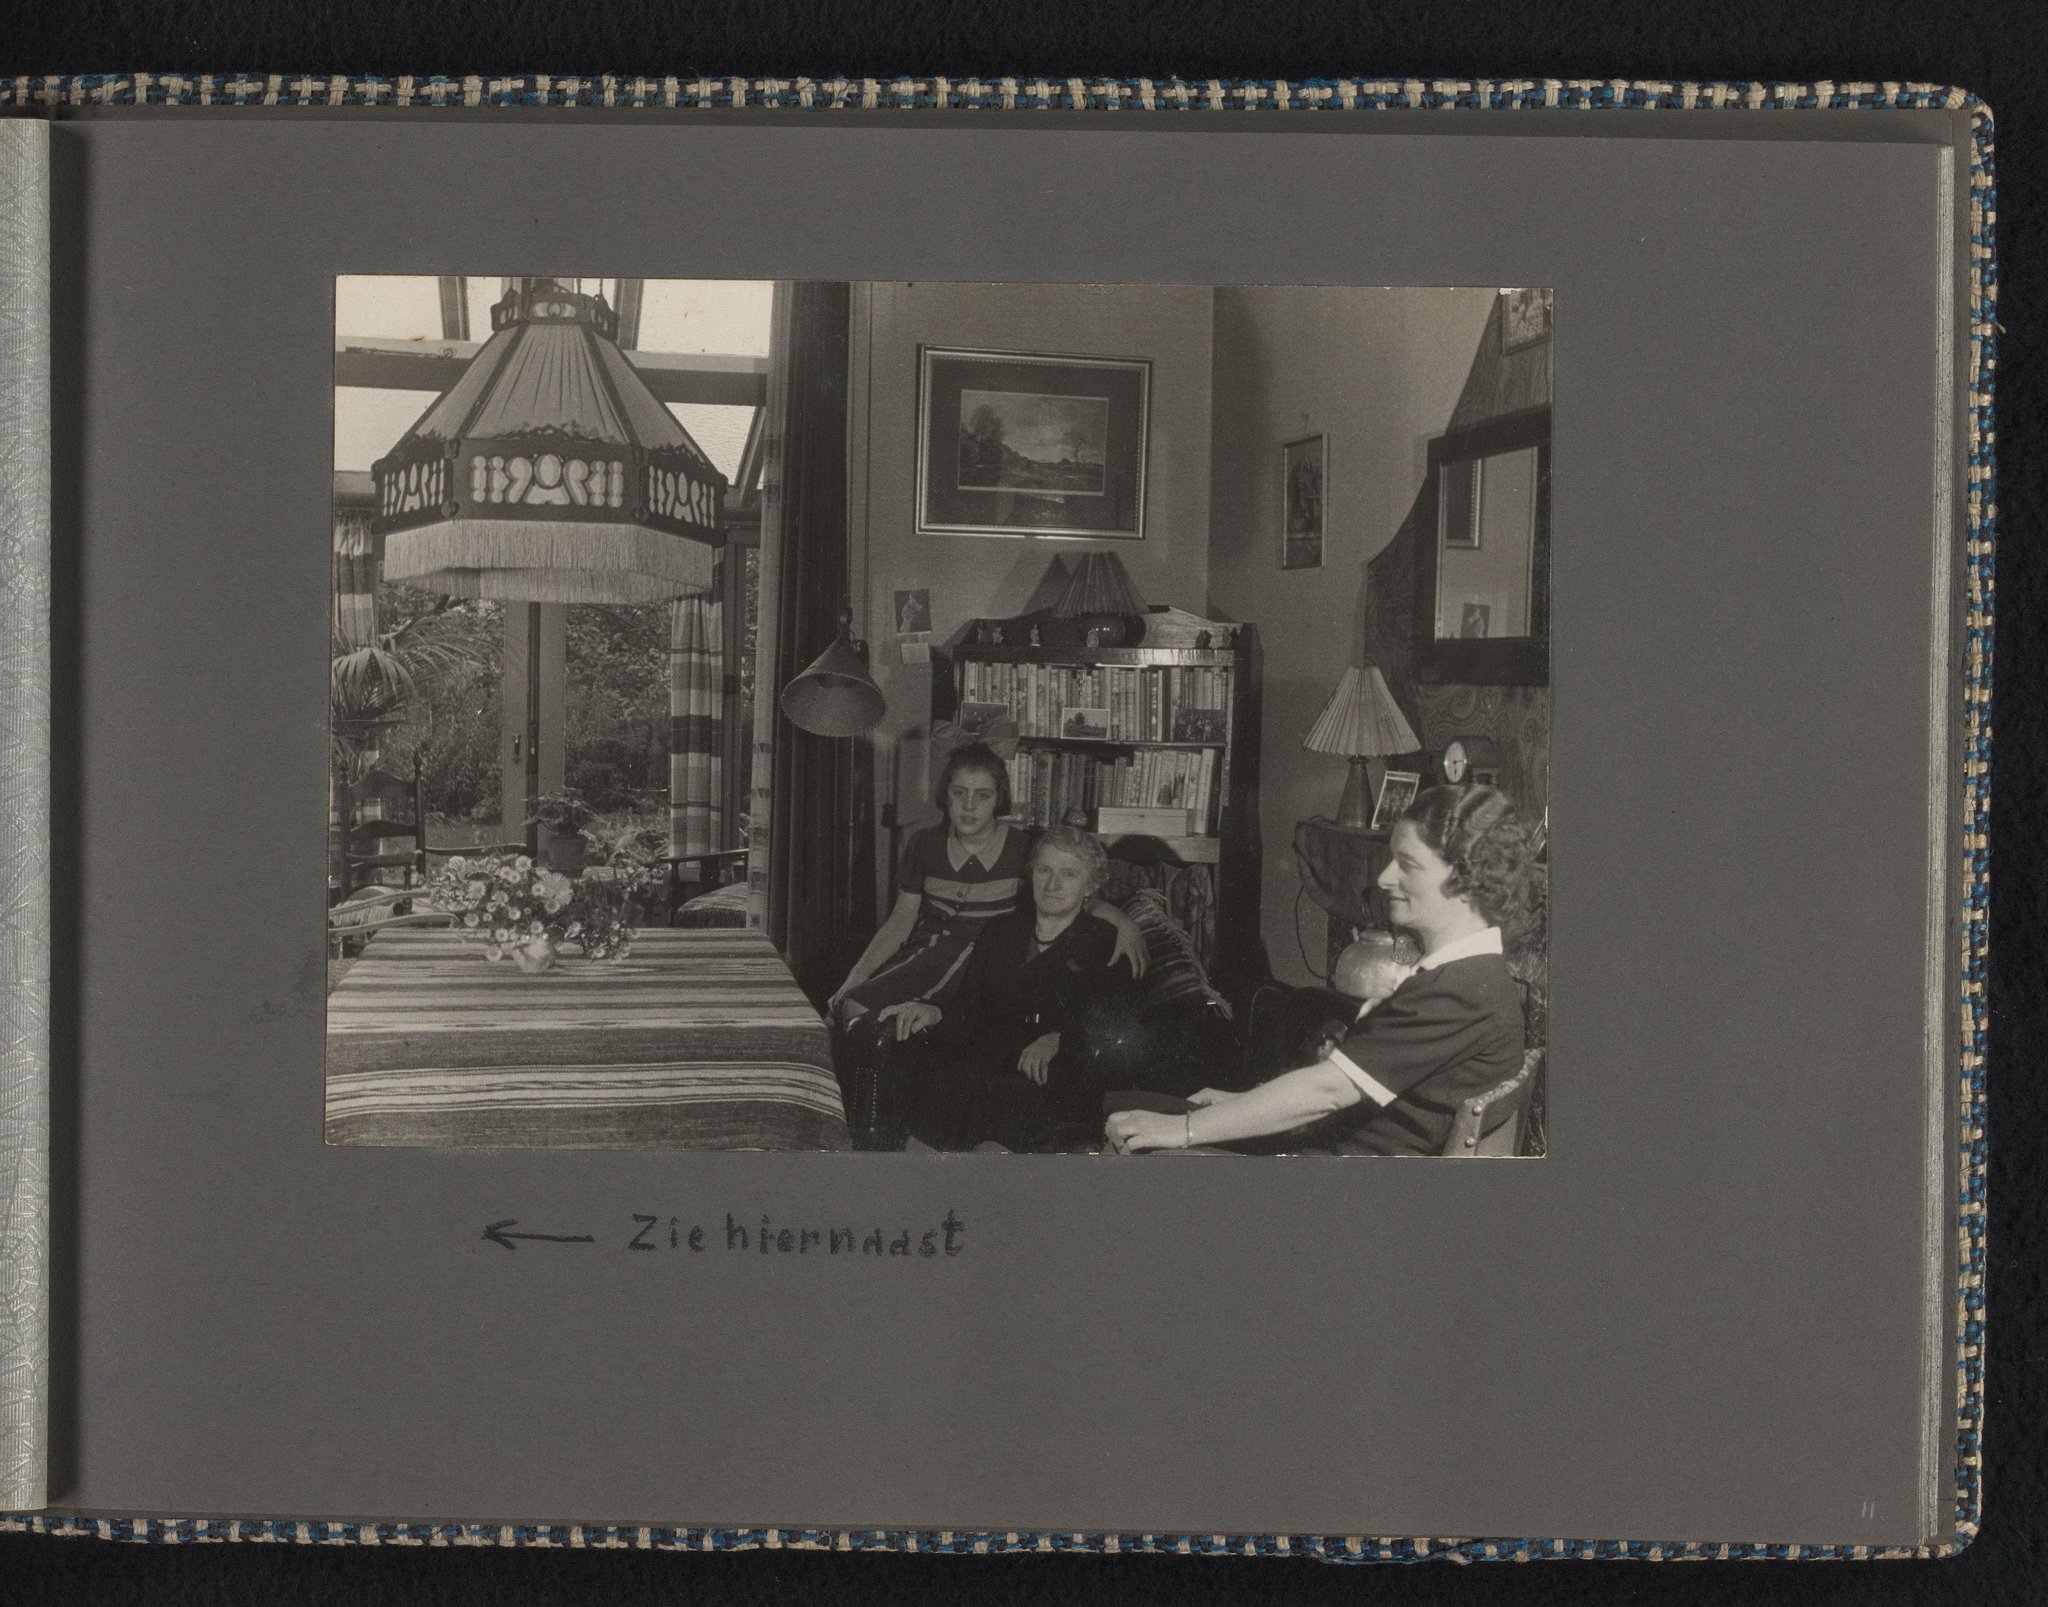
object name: photograph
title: Herfst 1943 in achterkamer Breelaan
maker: Anonymous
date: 1943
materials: paper, photographic support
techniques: gelatin silver print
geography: netherlands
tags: family life at home, mother and daughter(s) (family group), netherlands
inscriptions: inscription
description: Albumblad met een foto van de moeder met dochter en een oudere vrouw, in de achterkamer van een woning, herfst 1943. Onderdeel van het fotoalbum van het gezin van een Nederlandse officier in krijgsgevangenschap in Kamp Stanislau.